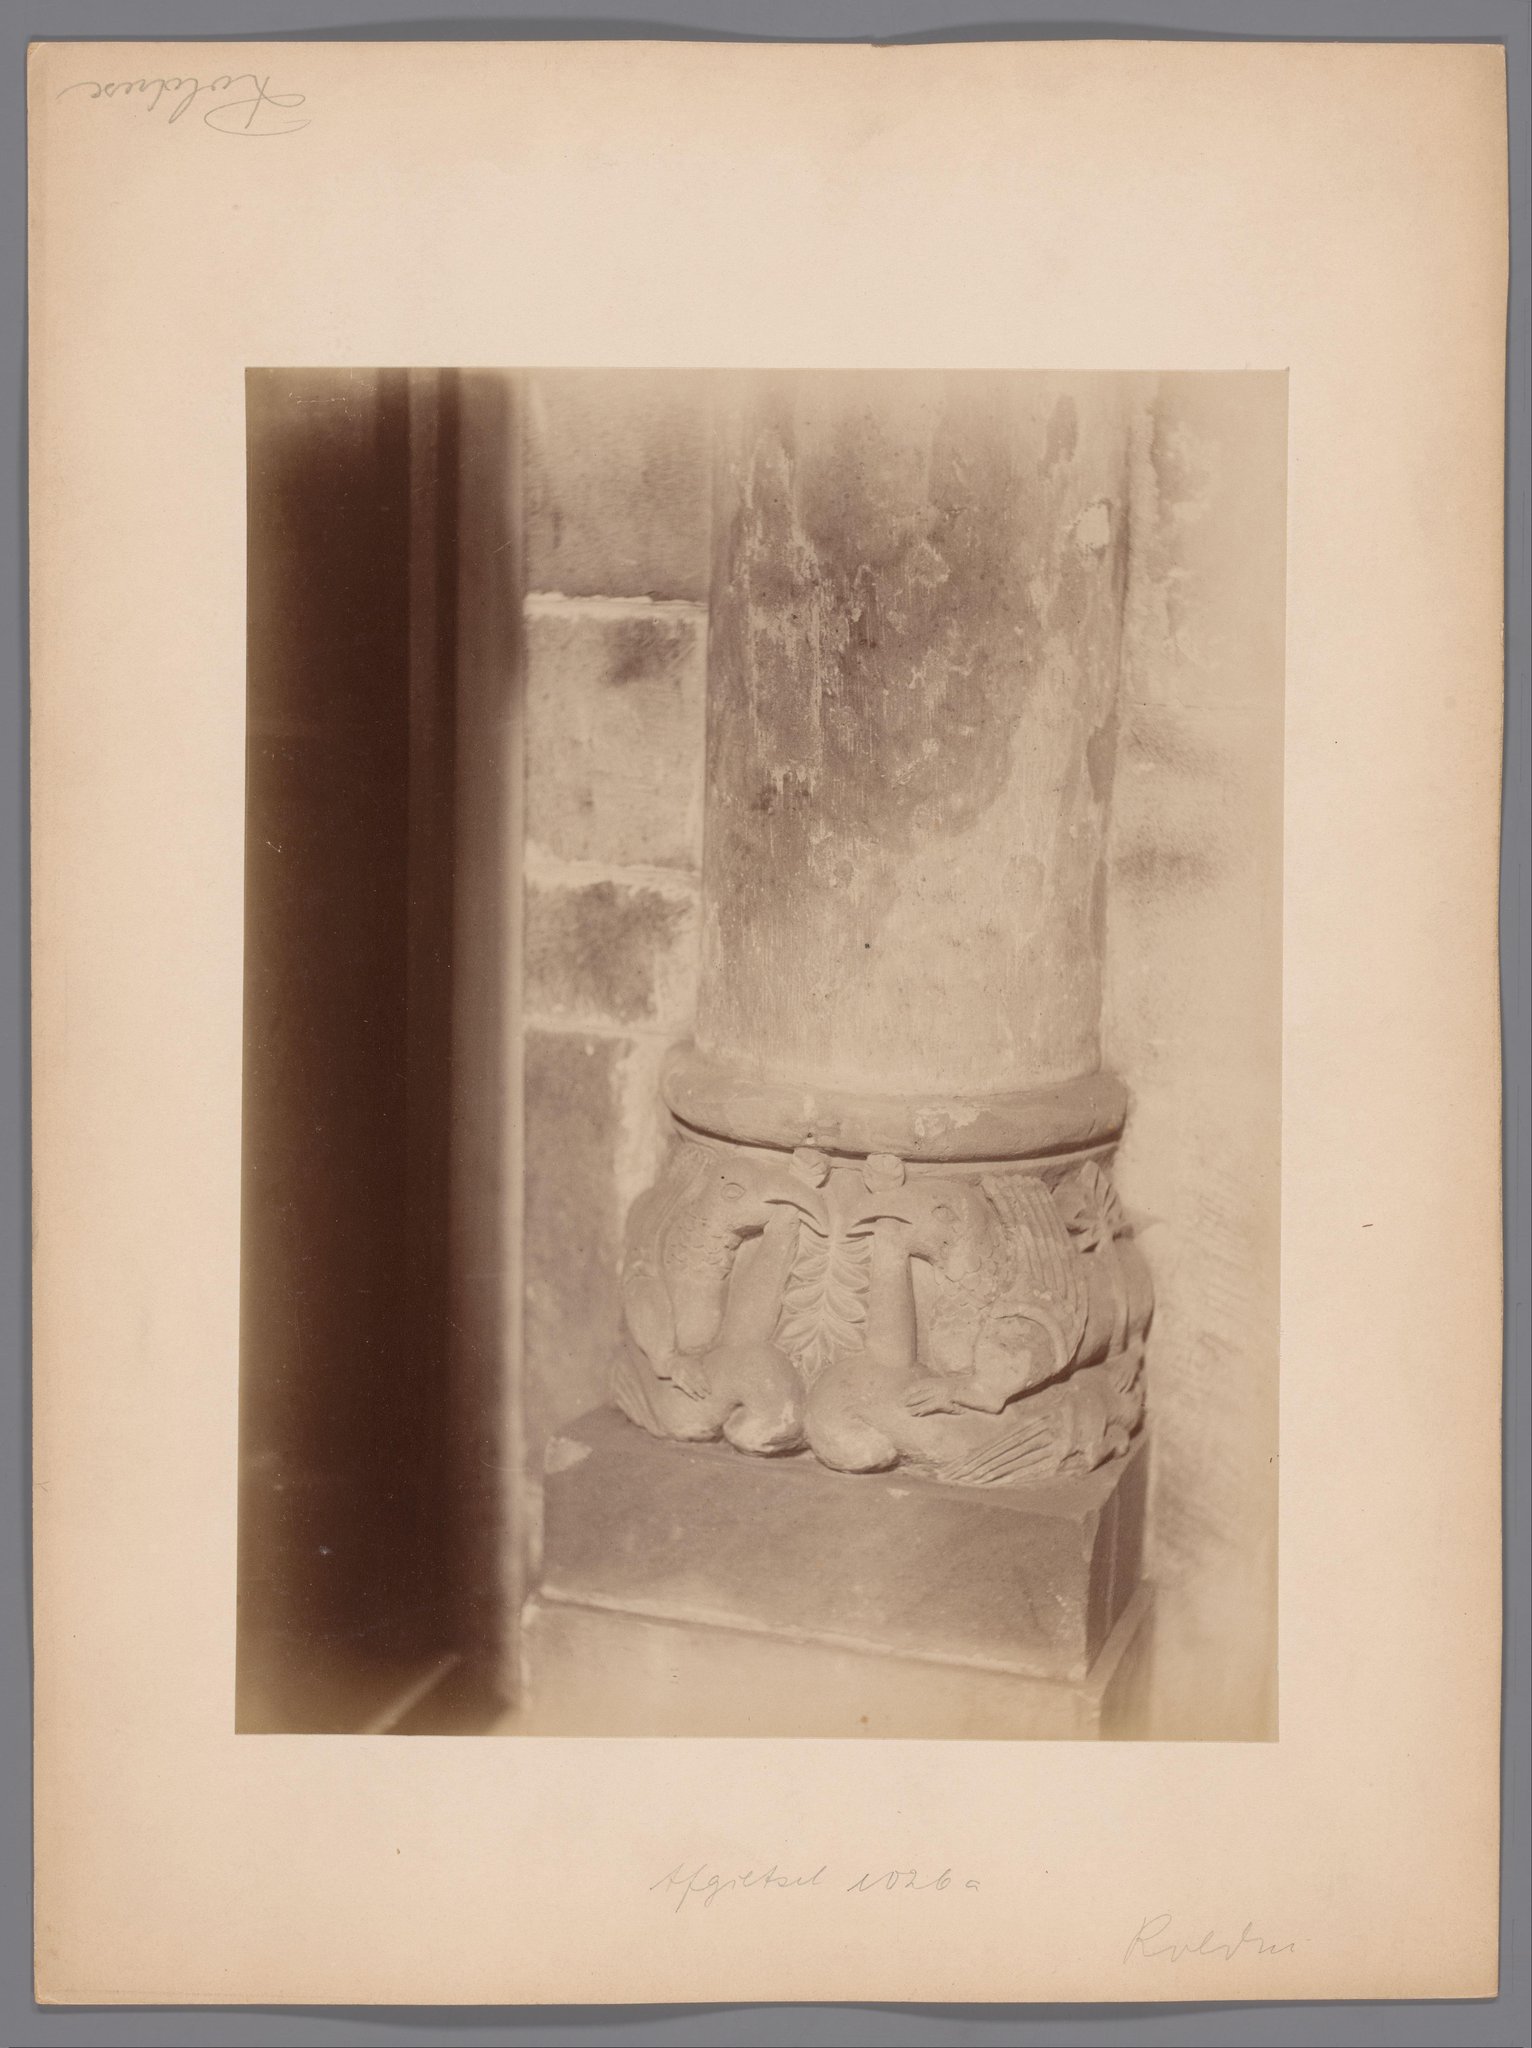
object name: photograph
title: Basement van een wandkolom in de Abdijkerk te Rolduc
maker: anoniem (monumentenzorg)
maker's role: fotograaf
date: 1890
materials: cardboard, photographic support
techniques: albumen print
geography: rolduc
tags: base (~ column, pillar)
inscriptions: annotation: ‘Basement van een der wandkolommen in de kerk te Rolduc/ oct 1980’, annotation: ‘Afgietsel No. 1026 a/ Rolduc’